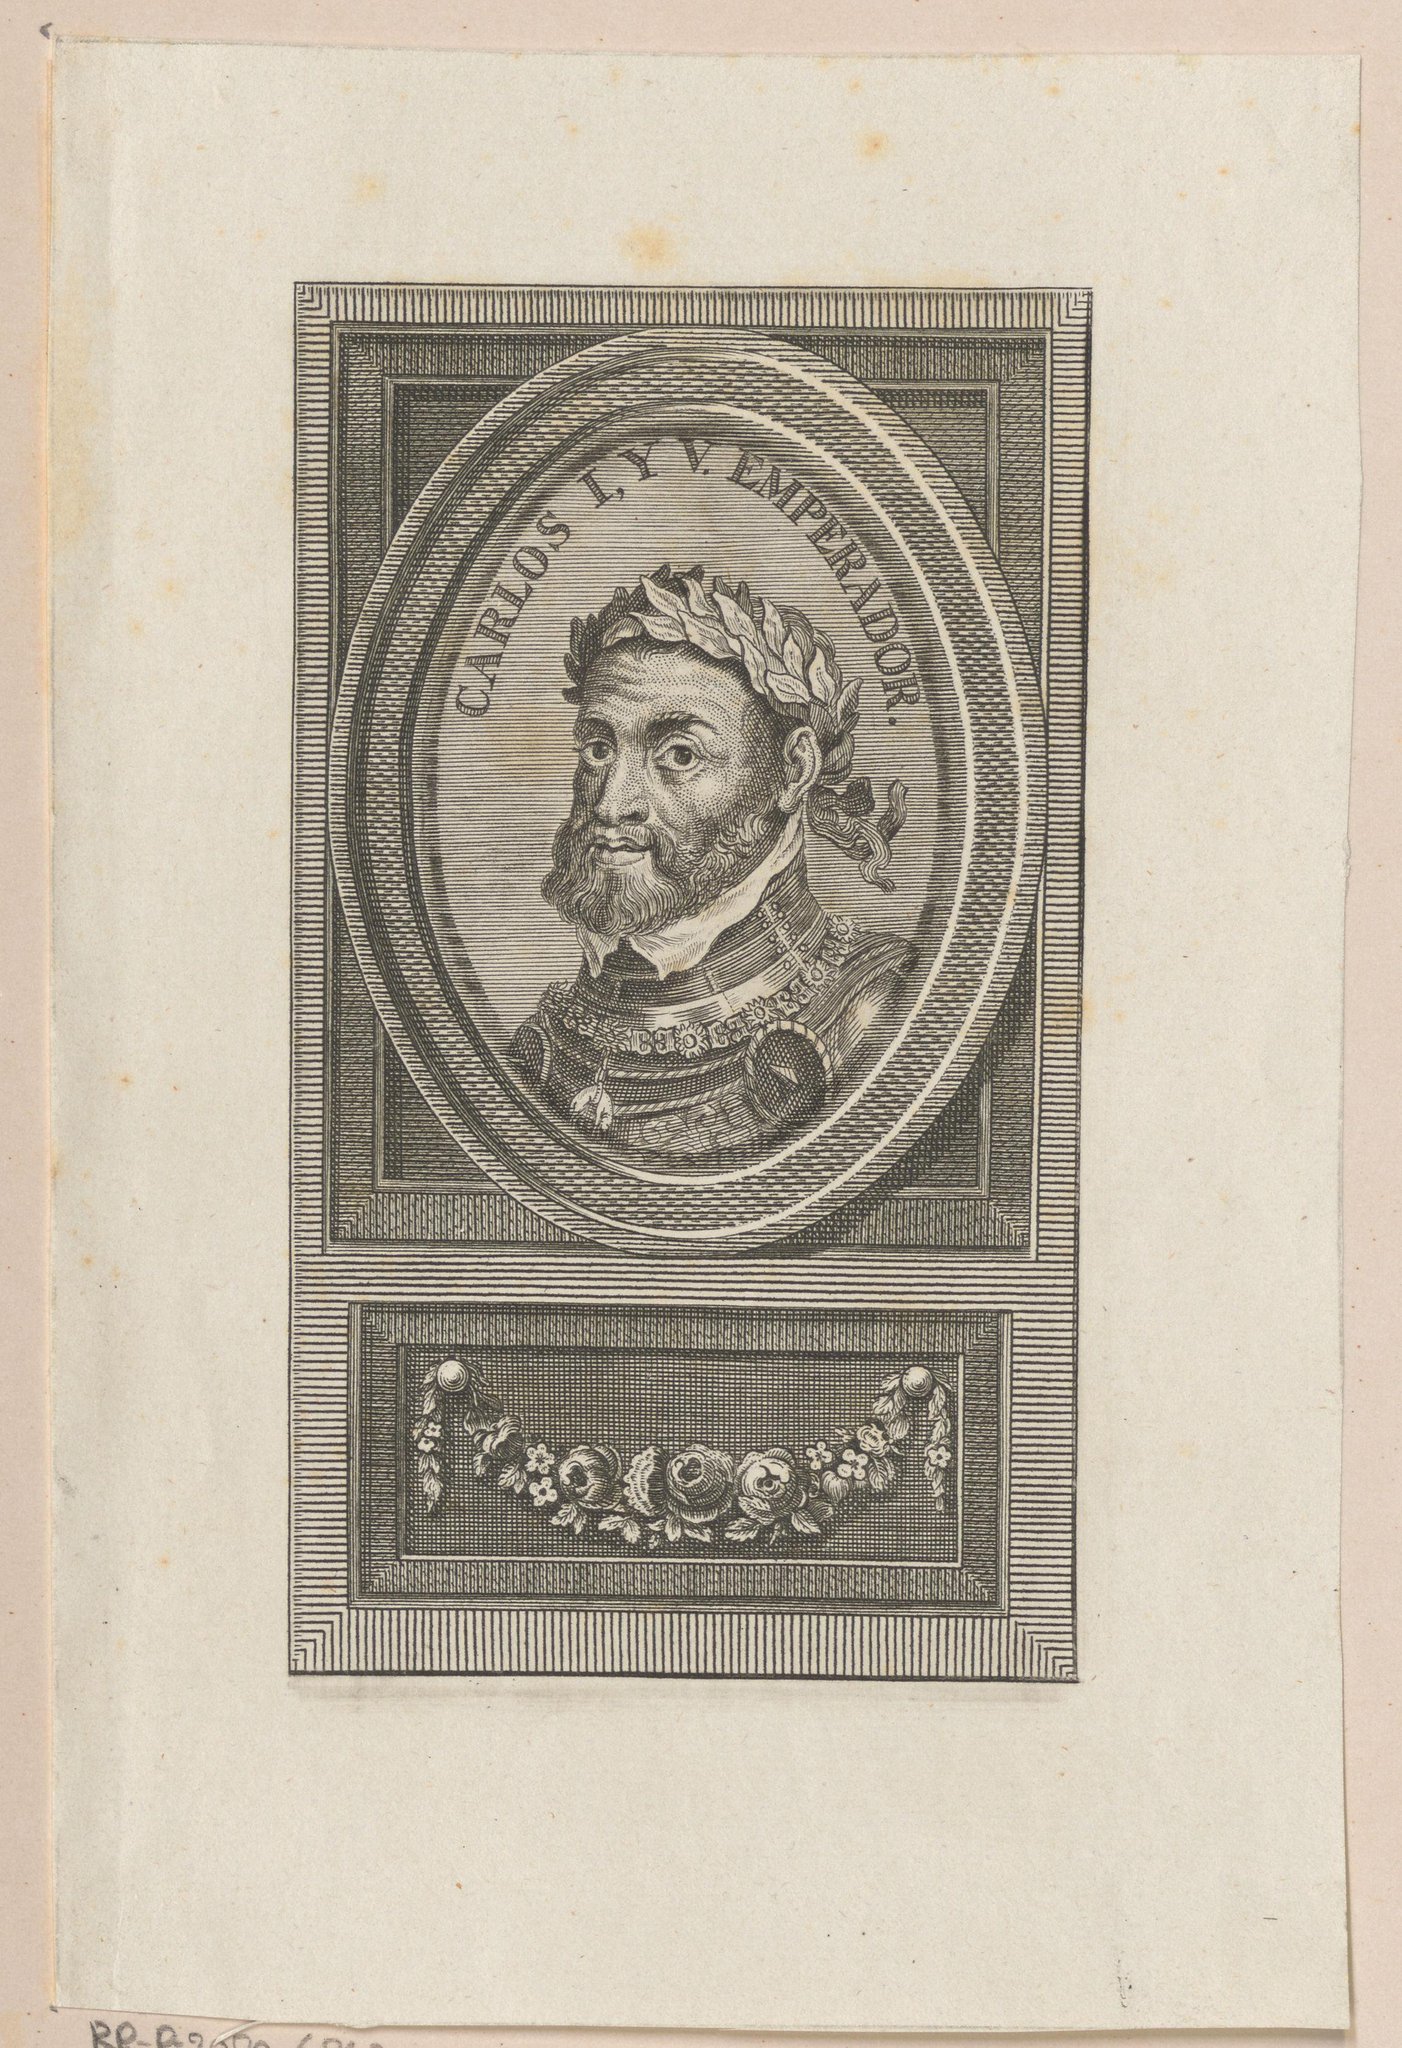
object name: print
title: Portret van keizer Karel V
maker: Anonymous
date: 1828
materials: paper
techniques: engraving, etching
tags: ghent, charles v (holy roman emperor and king of spain), historical persons, knighthood order of the golden fleece, king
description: Prent met andere omlijsting uit: Mariana, Juan de. Historia General de España. Nueva edición (...) Madrid: Hijos de Doña Catalina Piñuela, 1828.